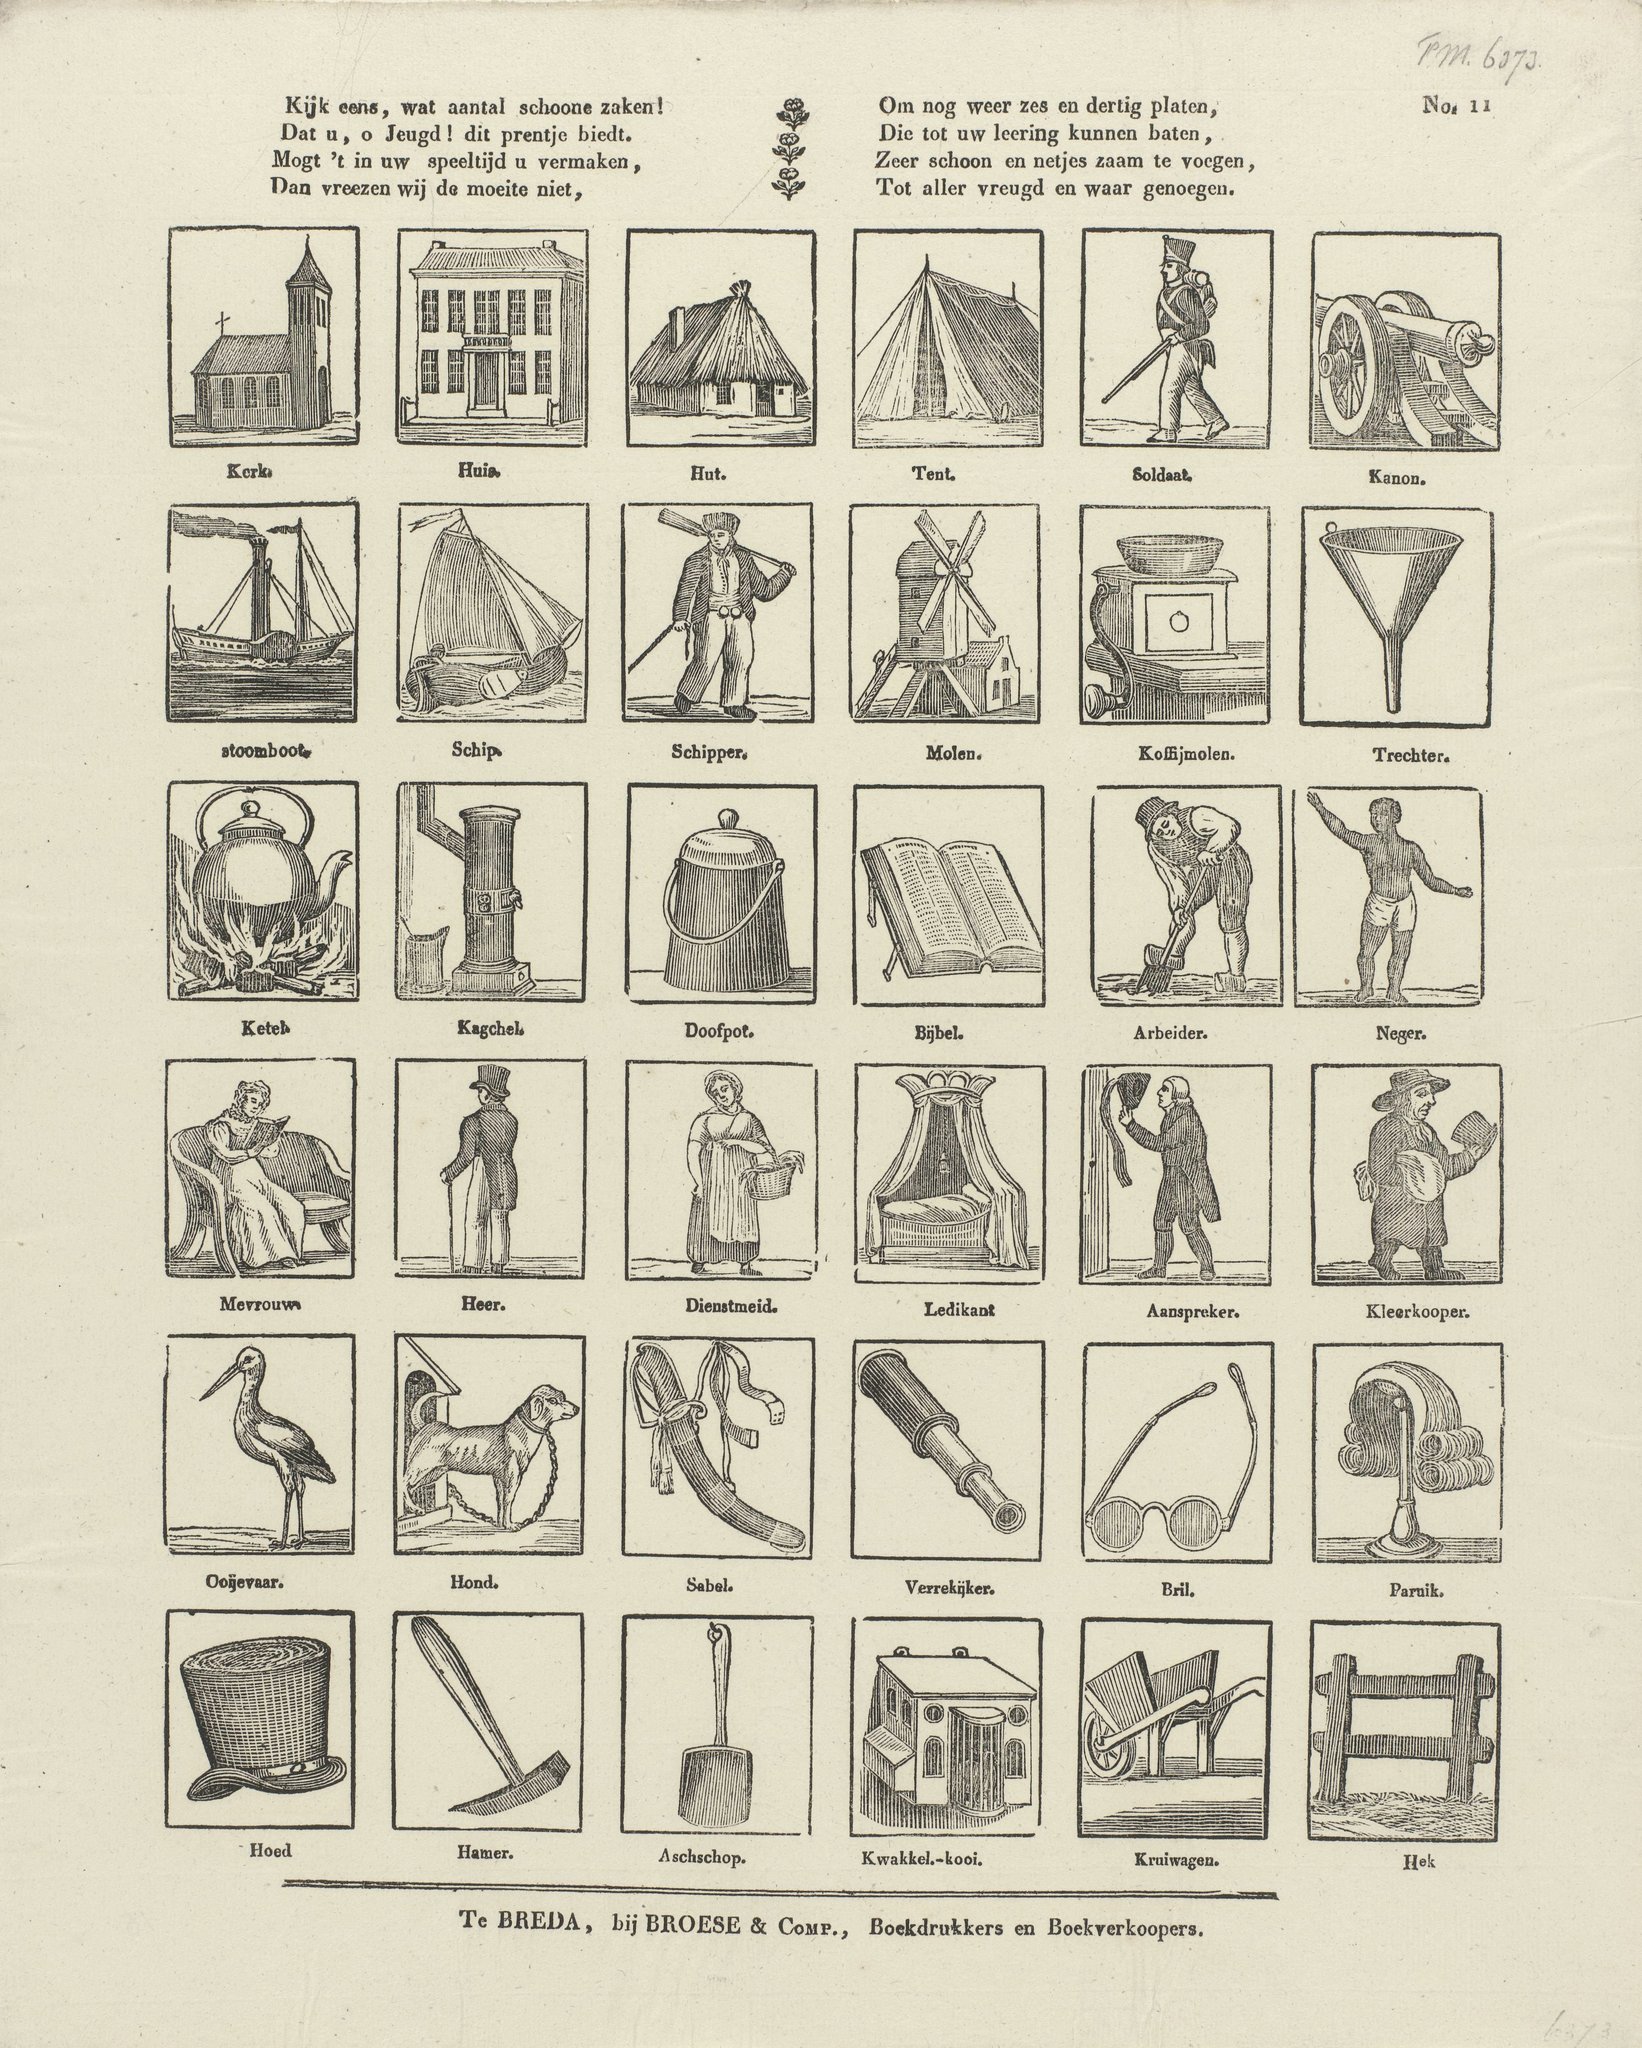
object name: print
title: Kijke eens, wat aantal schoone zaken! (...)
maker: Anonymous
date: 1828-1853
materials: paper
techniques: letterpress printing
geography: breda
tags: shore-birds and wading-birds: stork, wig, hut, cabin, lodge, seaman: sailor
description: Blad met 36 voorstellingen van voorwerpen, gebouwen, dieren en figuren, zoals een hut, een schipper, een ooievaar en een pruik. Onder elke voorstelling een onderschrift. Genummerd rechtsboven: No. 11.